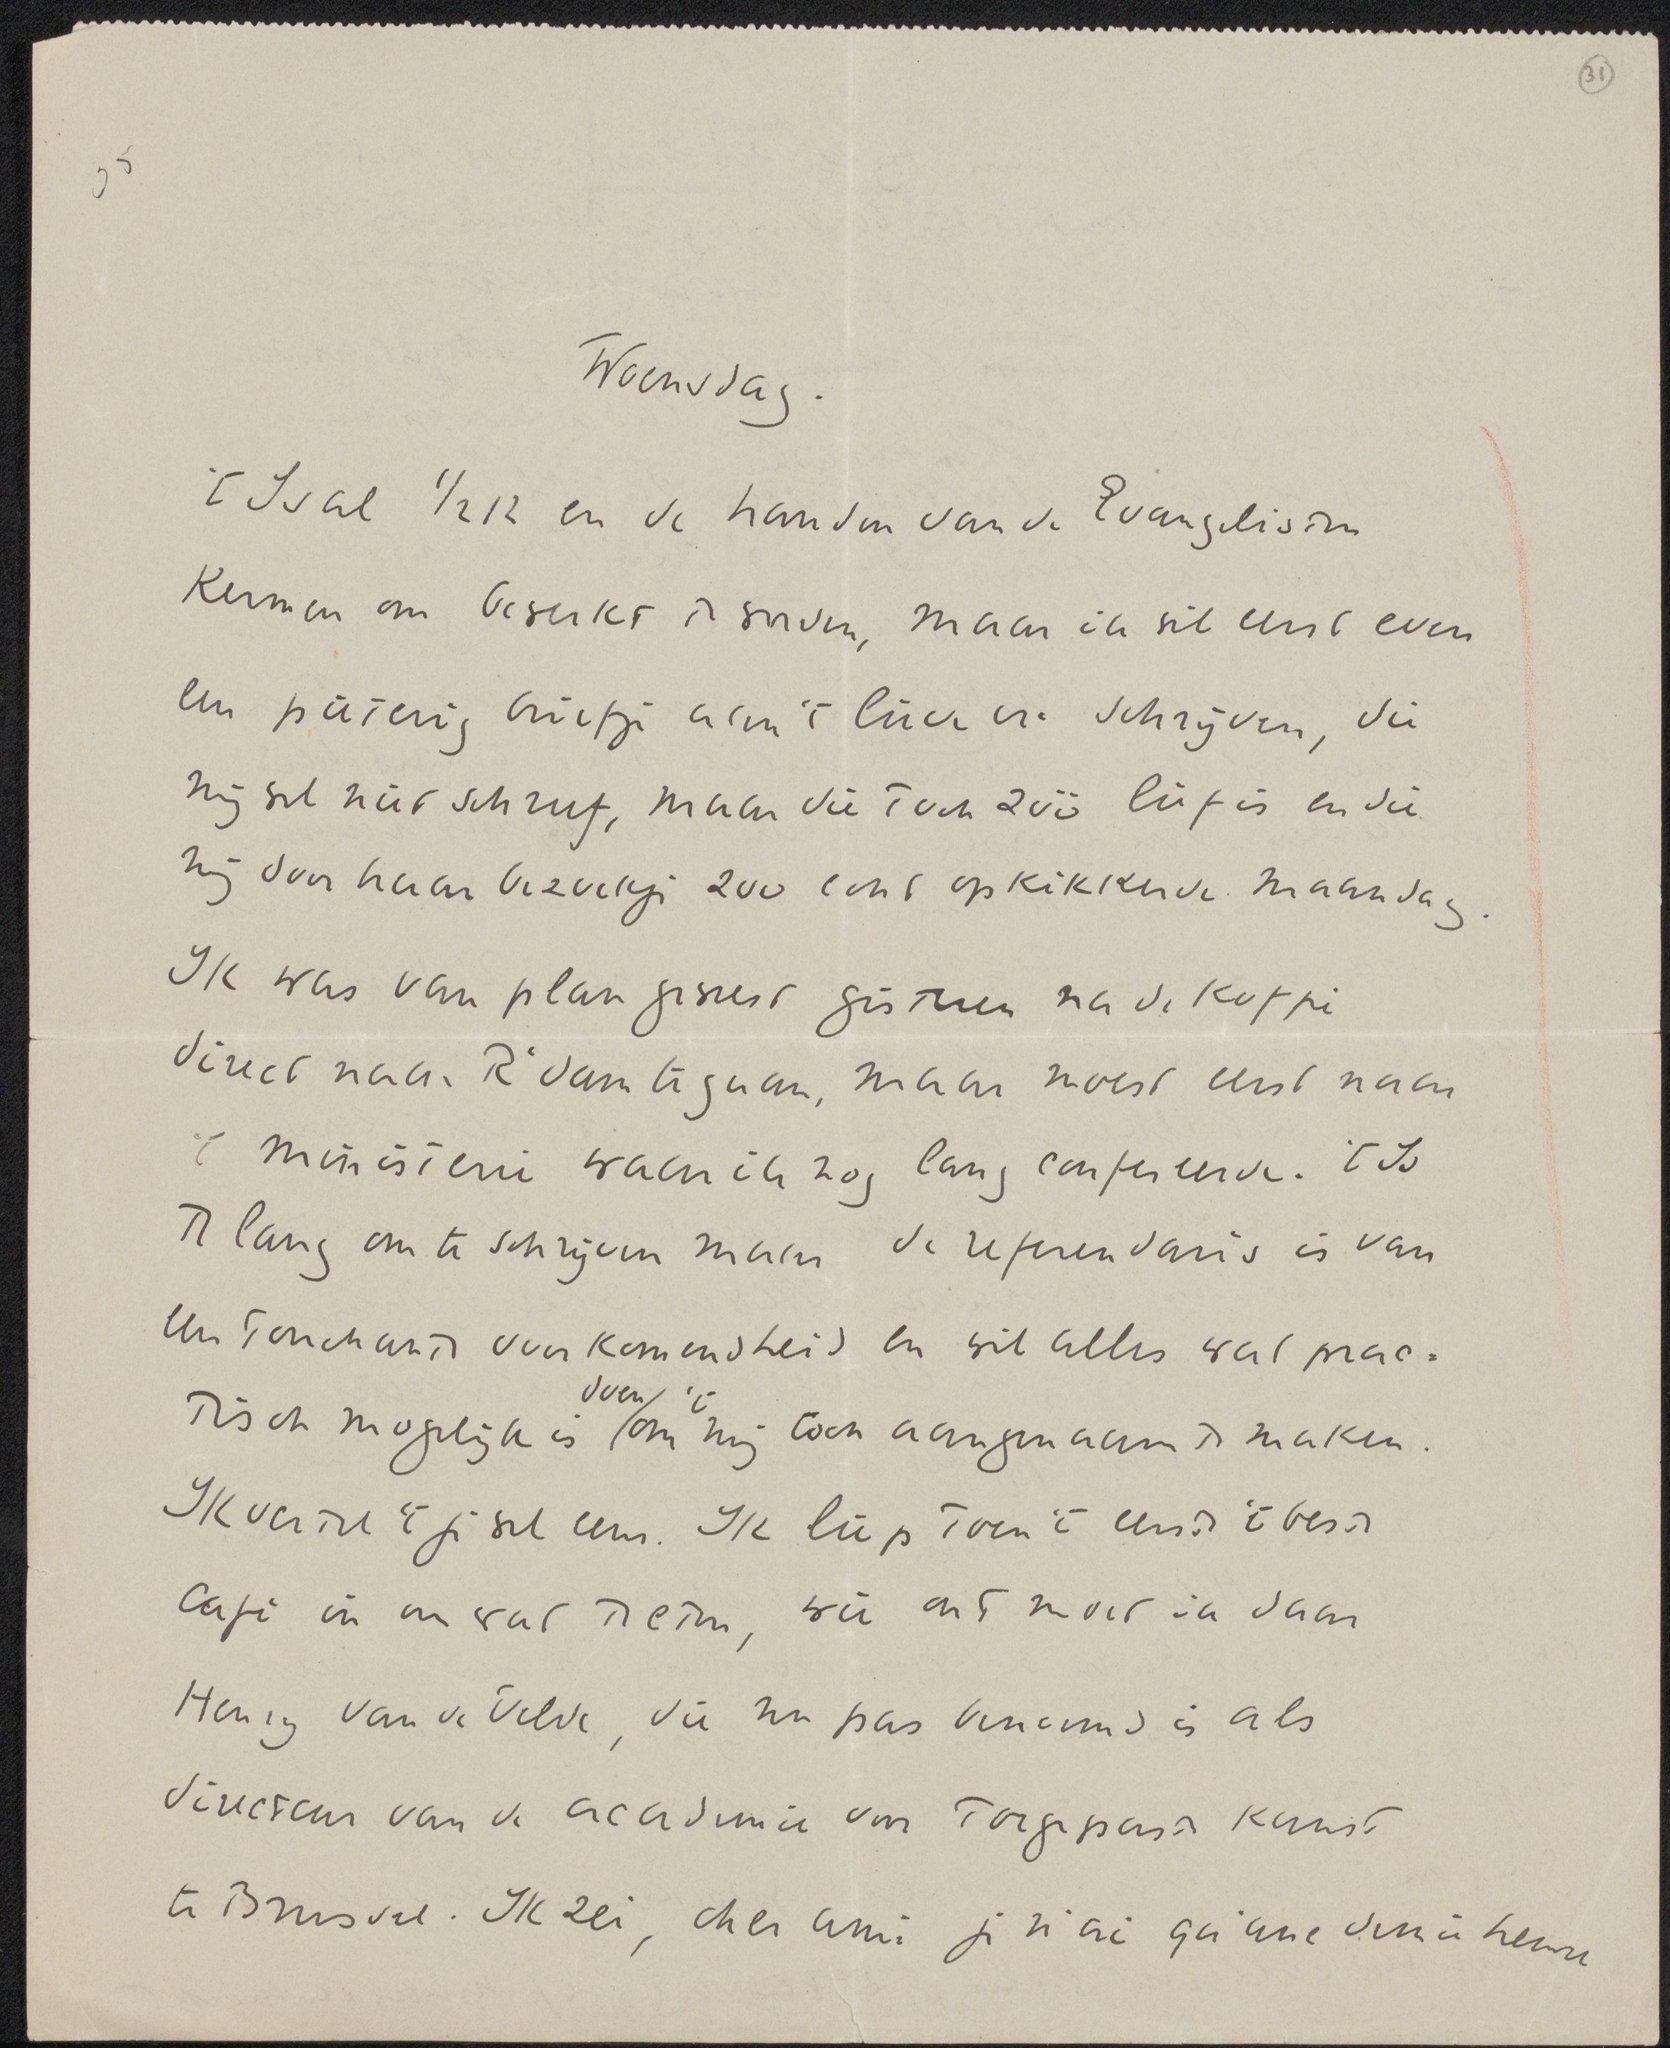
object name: letter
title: Brief aan Ina van Eibergen Santhagens-Waller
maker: richard nicolaüs roland holst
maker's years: 1868-1938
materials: ink, paper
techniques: pen, writing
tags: antwerp, painter, draughtsman, henry van de velde (1863-1957), haarlem, amsterdam, print maker, ina van eibergen santhagens-waller, applied arts, arts and crafts; industrial design, diseases, rotterdam, brussels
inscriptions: collector's mark: ‘RPK’